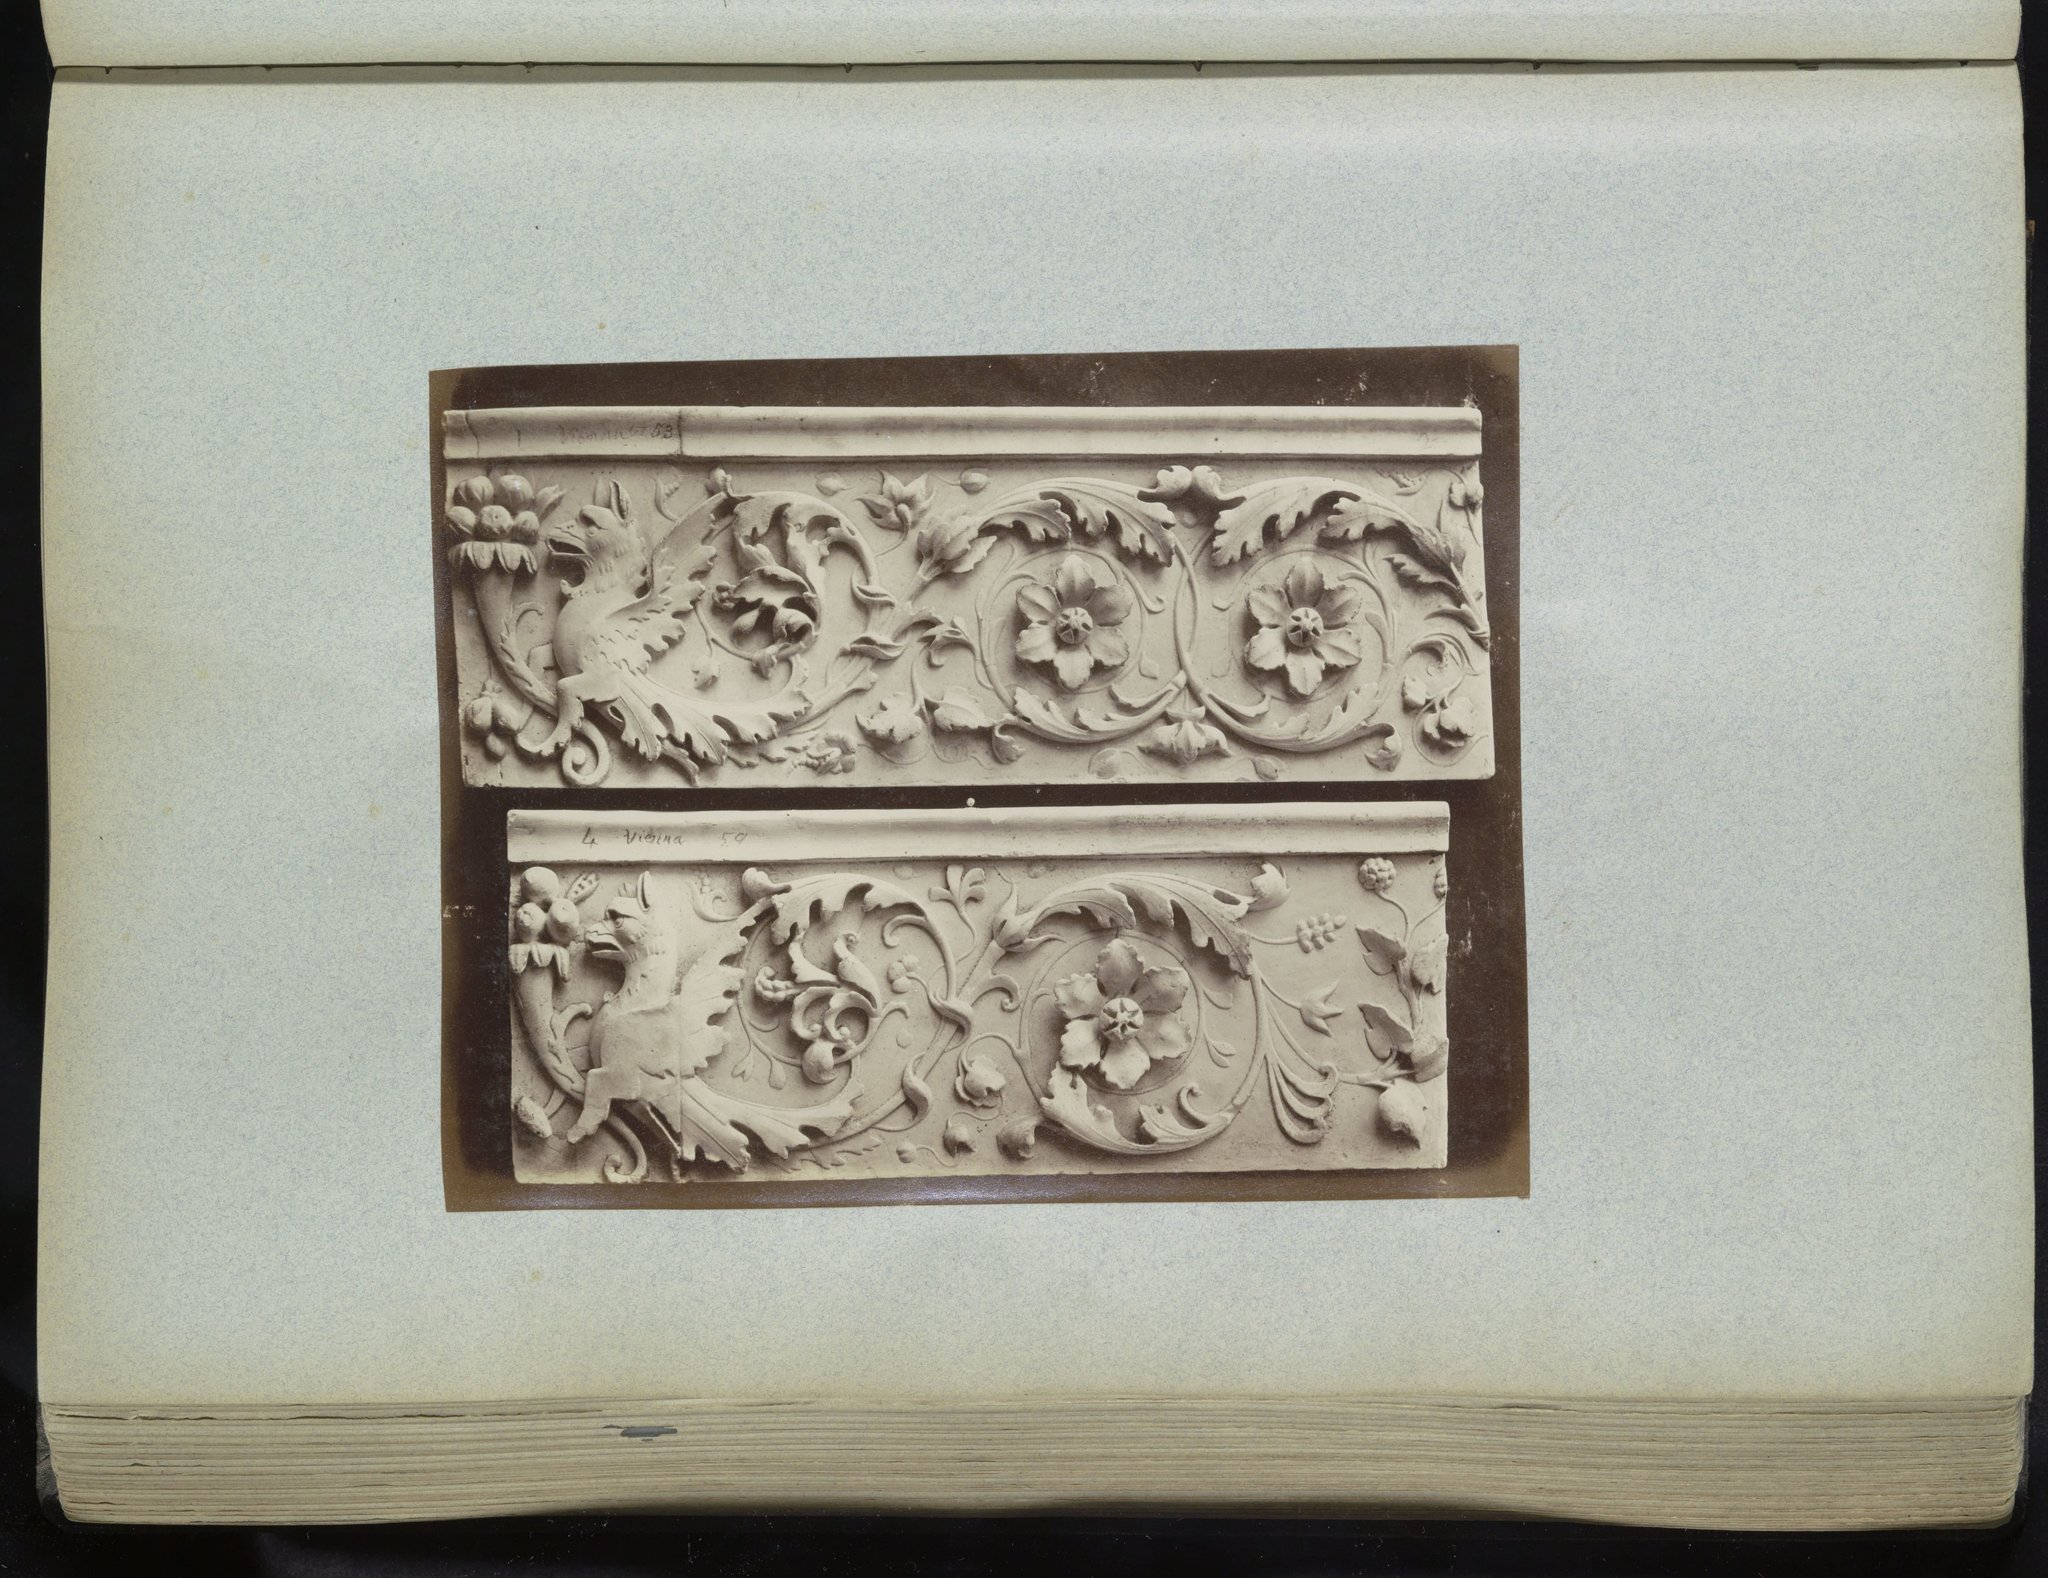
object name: album leaf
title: Twee gipsen afgietsels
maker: Anonymous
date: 1875-1900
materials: paper, photographic support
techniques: albumen print